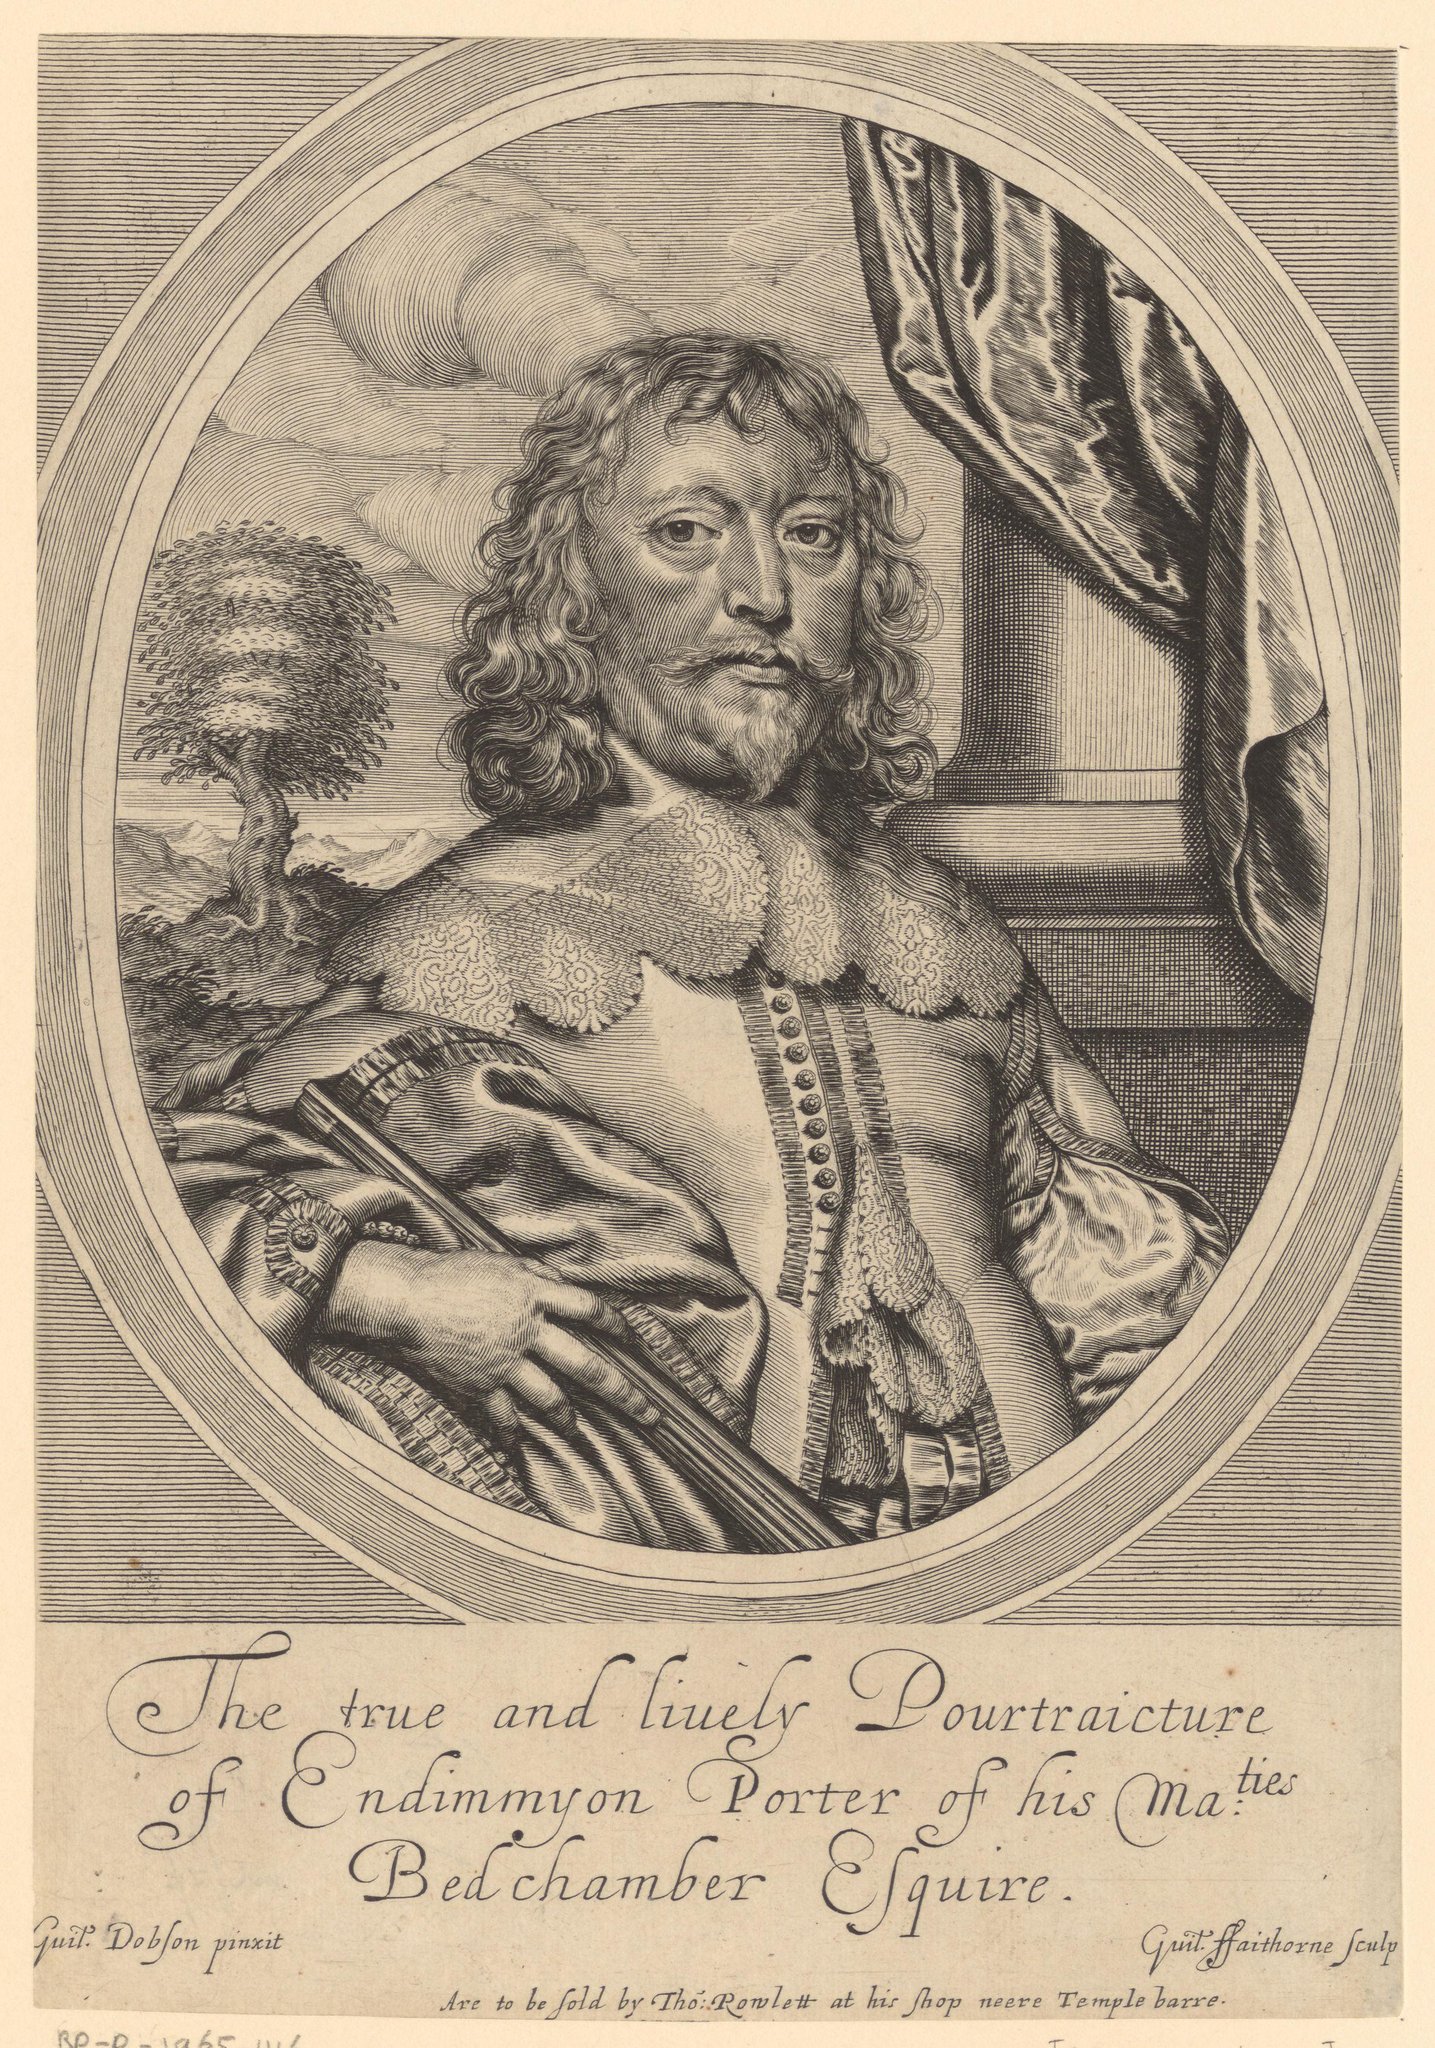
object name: print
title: Portret van Endymion Porter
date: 1645-1646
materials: paper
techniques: engraving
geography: london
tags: politician, historical persons, politician, e.g. party leader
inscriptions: watermark, collector's mark: Lugt 2228, collector's mark: Lugt 2760